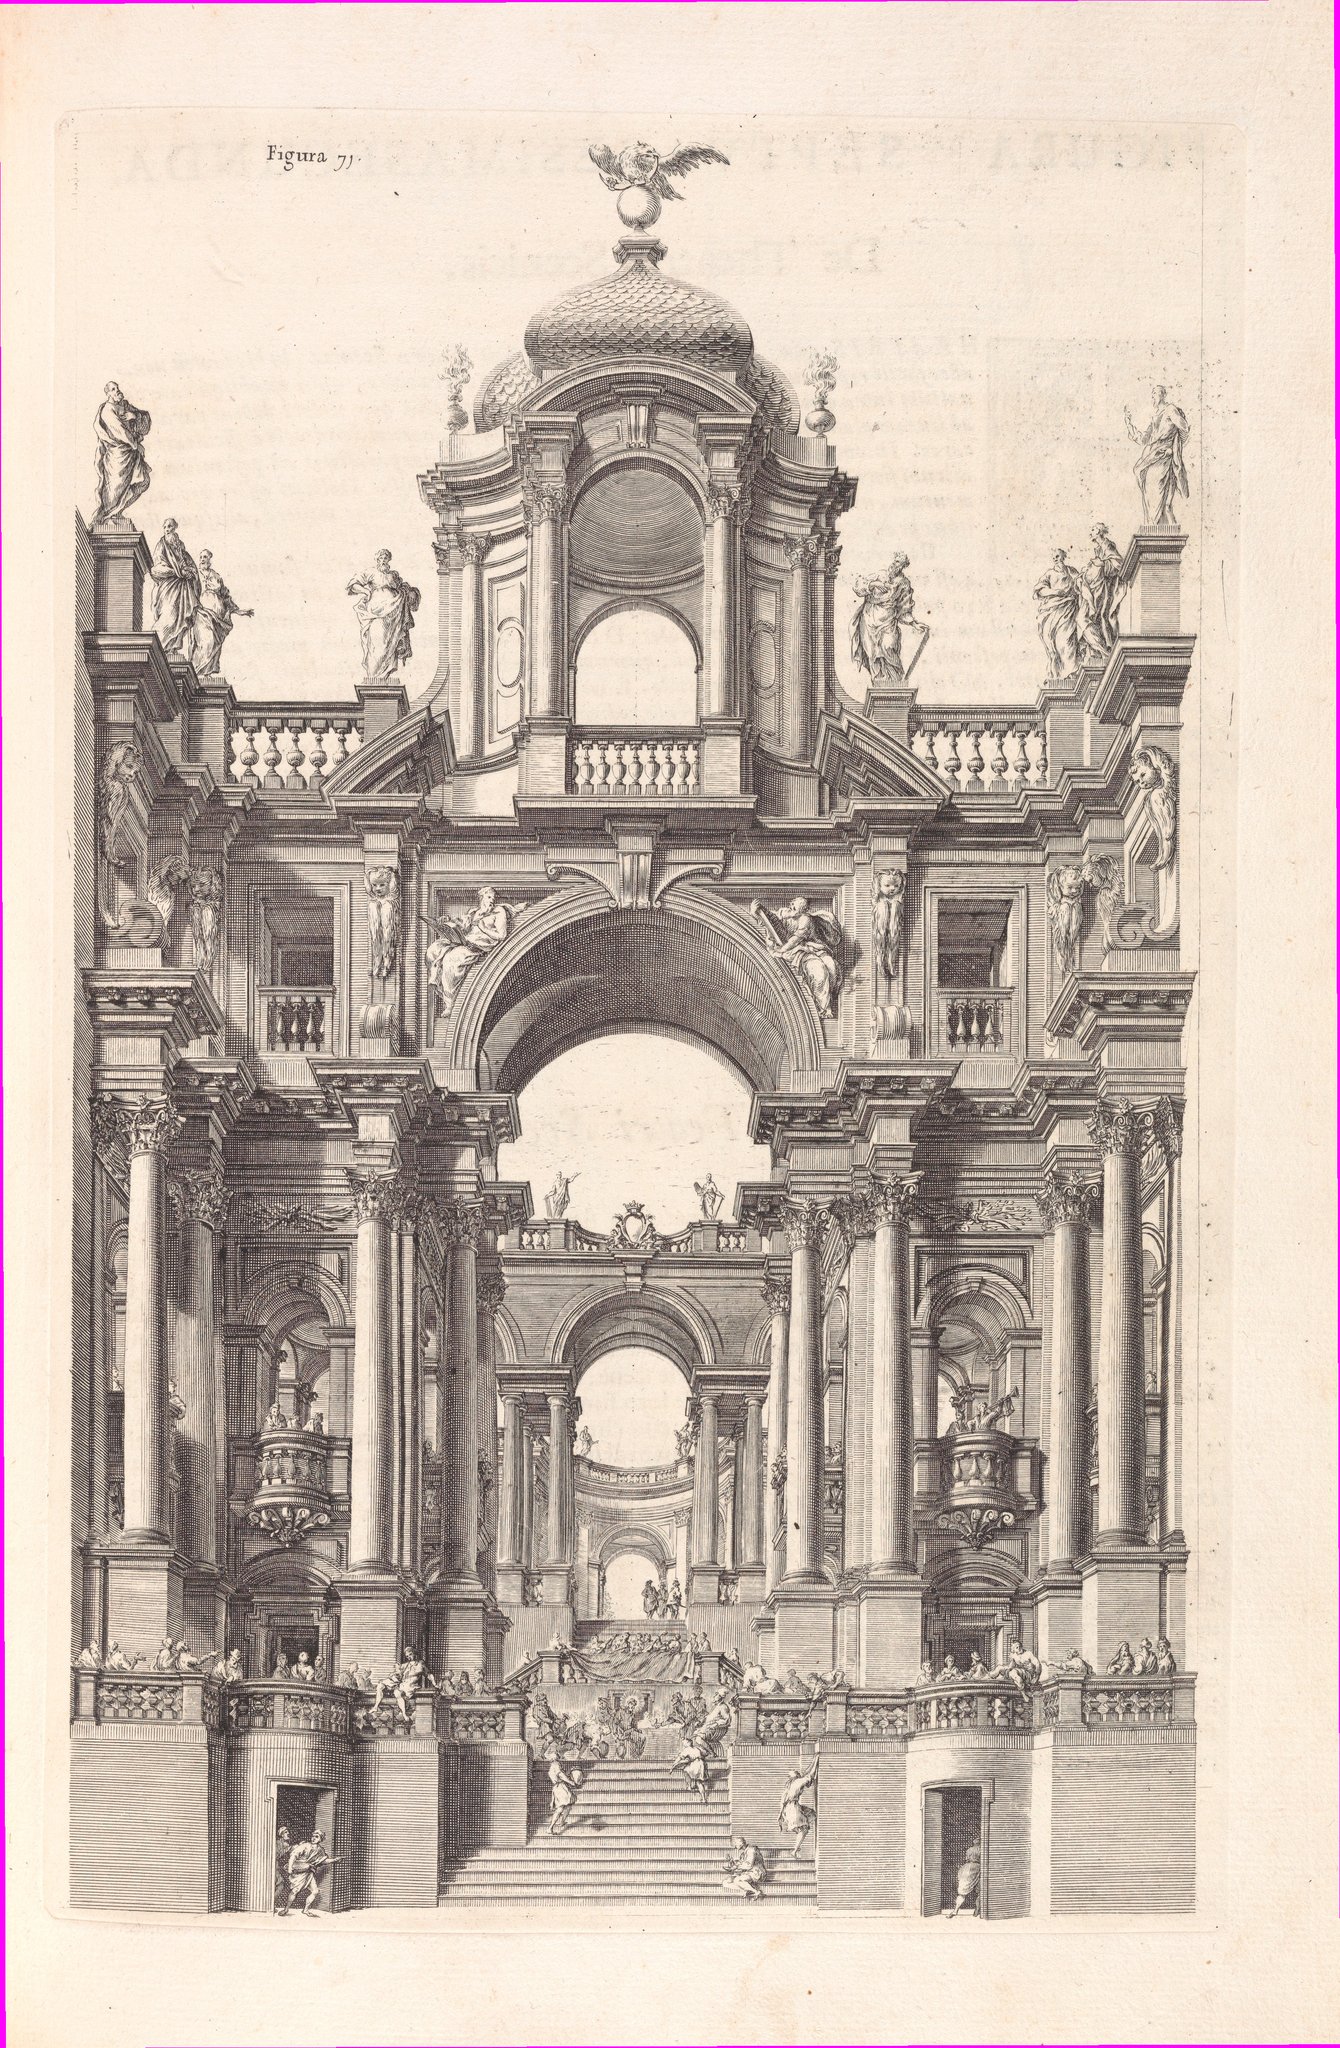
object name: book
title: Perspectiva pictorum et architectorum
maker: andrea pozzo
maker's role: author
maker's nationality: italian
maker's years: 1642-1709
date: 1693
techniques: engraving, printing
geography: italy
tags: architecture